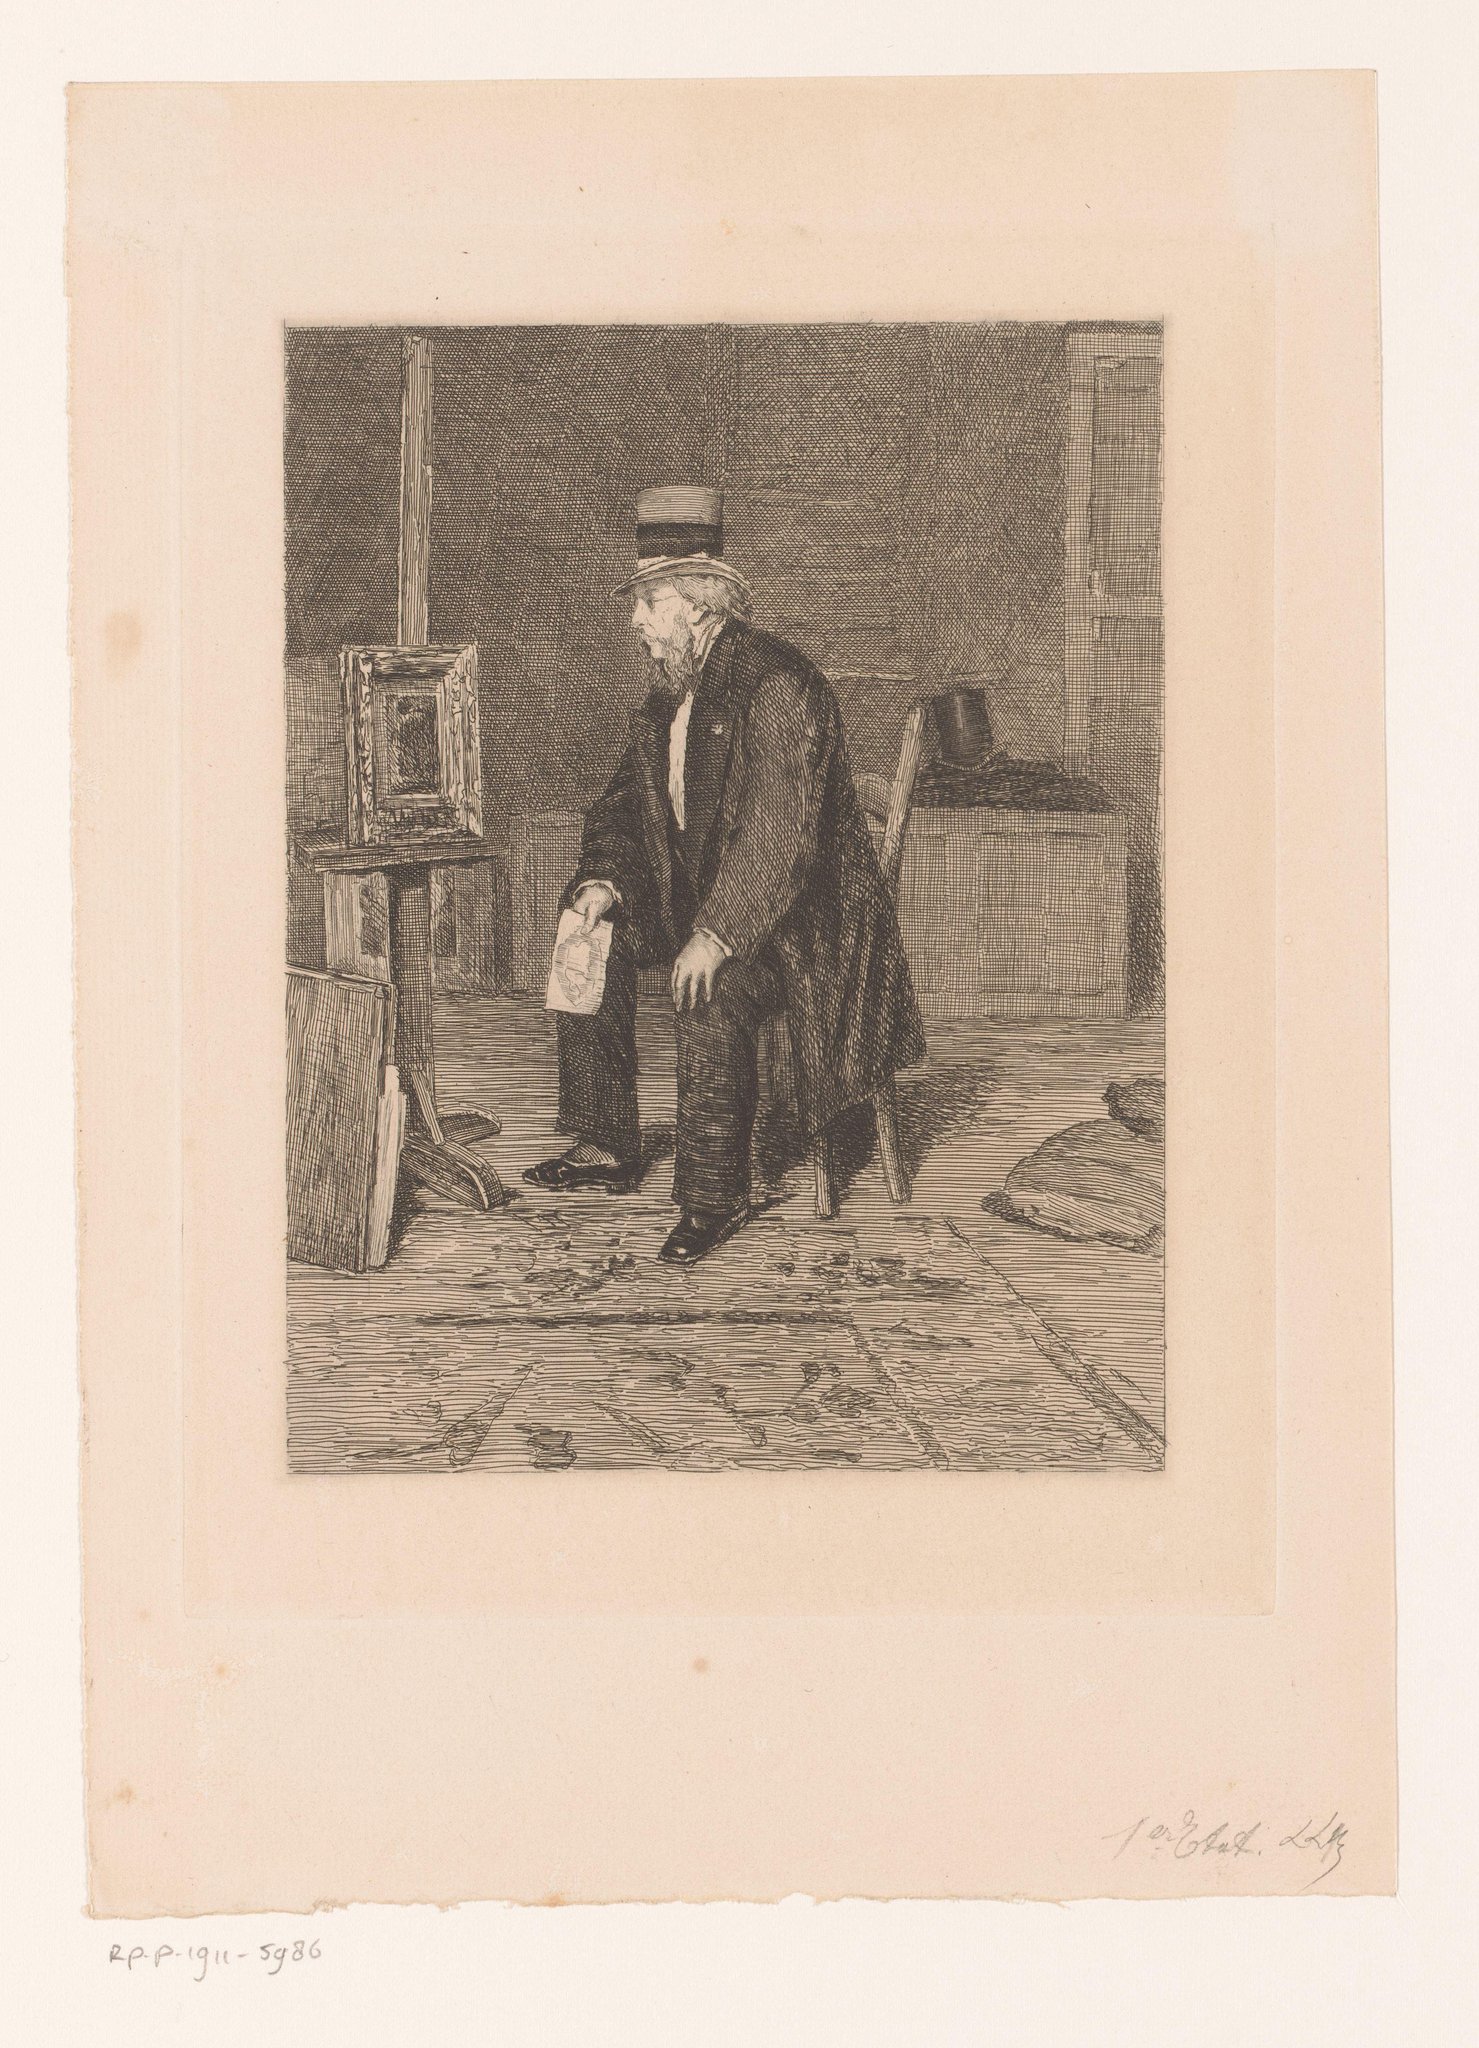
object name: print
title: Interieur met een man met hoge hoed die een schilderij bekijkt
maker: louis le nain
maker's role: print maker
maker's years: 1851-1939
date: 1861-1911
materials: paper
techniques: etching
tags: sitting figure, interior of the house, painting, drawing and the graphic arts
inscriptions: collector's mark: Lugt 2228, inscription: ‘1er Etat LLN’